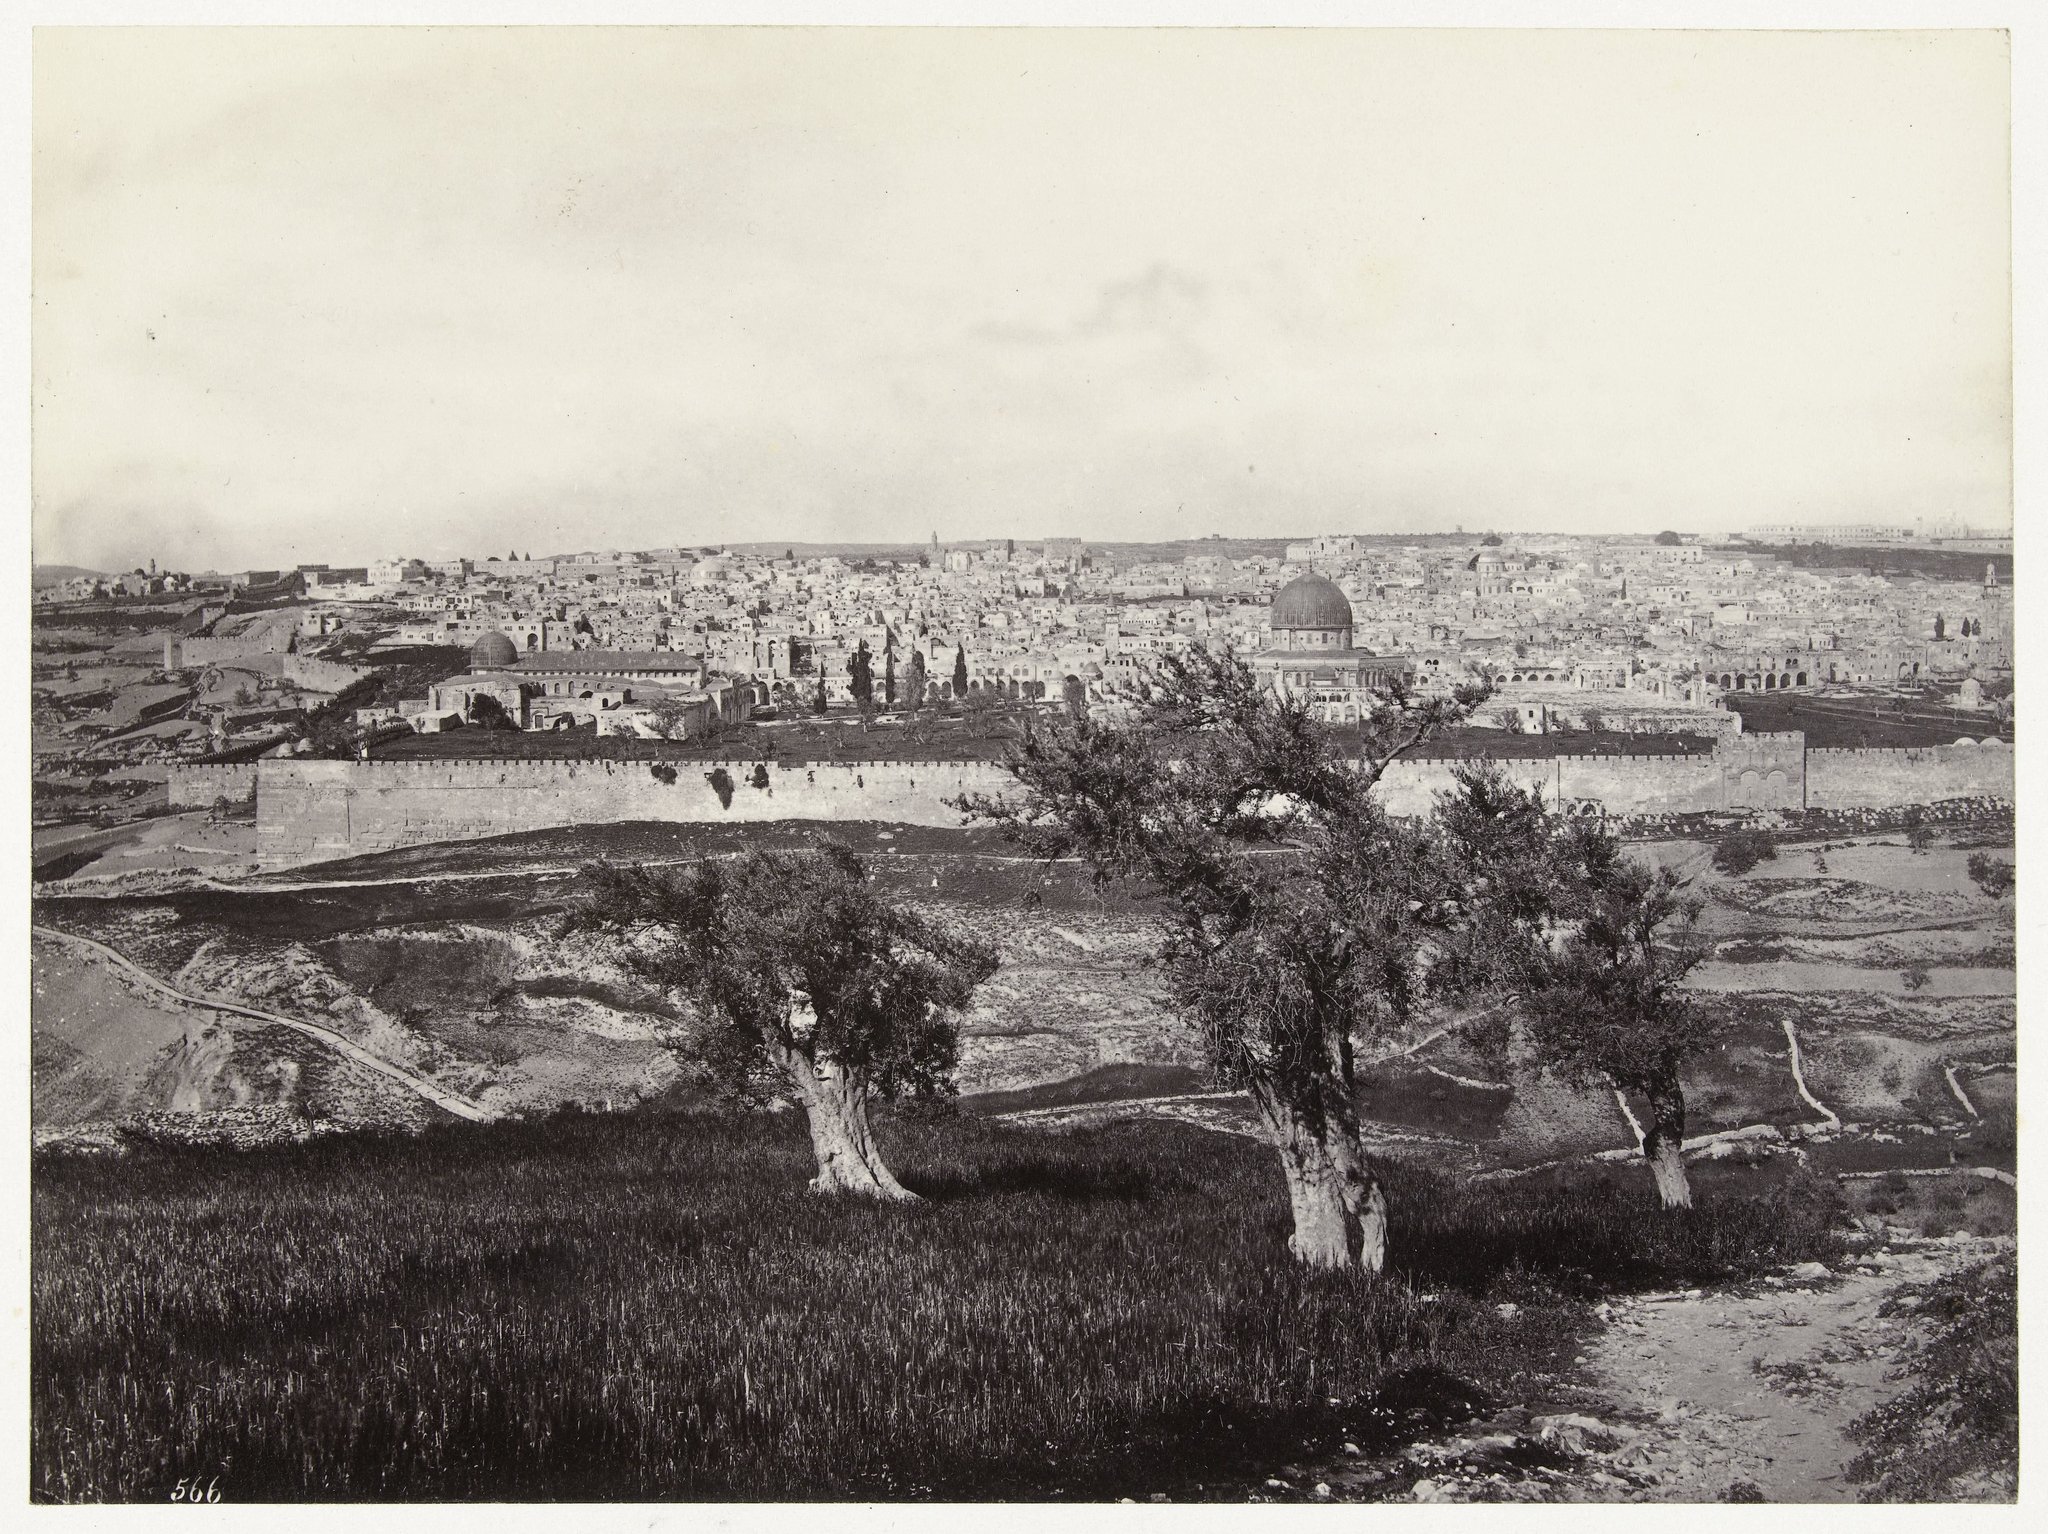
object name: photograph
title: Gezicht op Jeruzalem vanaf de Olijfberg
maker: francis frith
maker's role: publisher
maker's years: 1822-1898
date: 1857-1858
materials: cardboard, paper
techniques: albumen print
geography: olijfberg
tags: city-view in general; 'veduta'